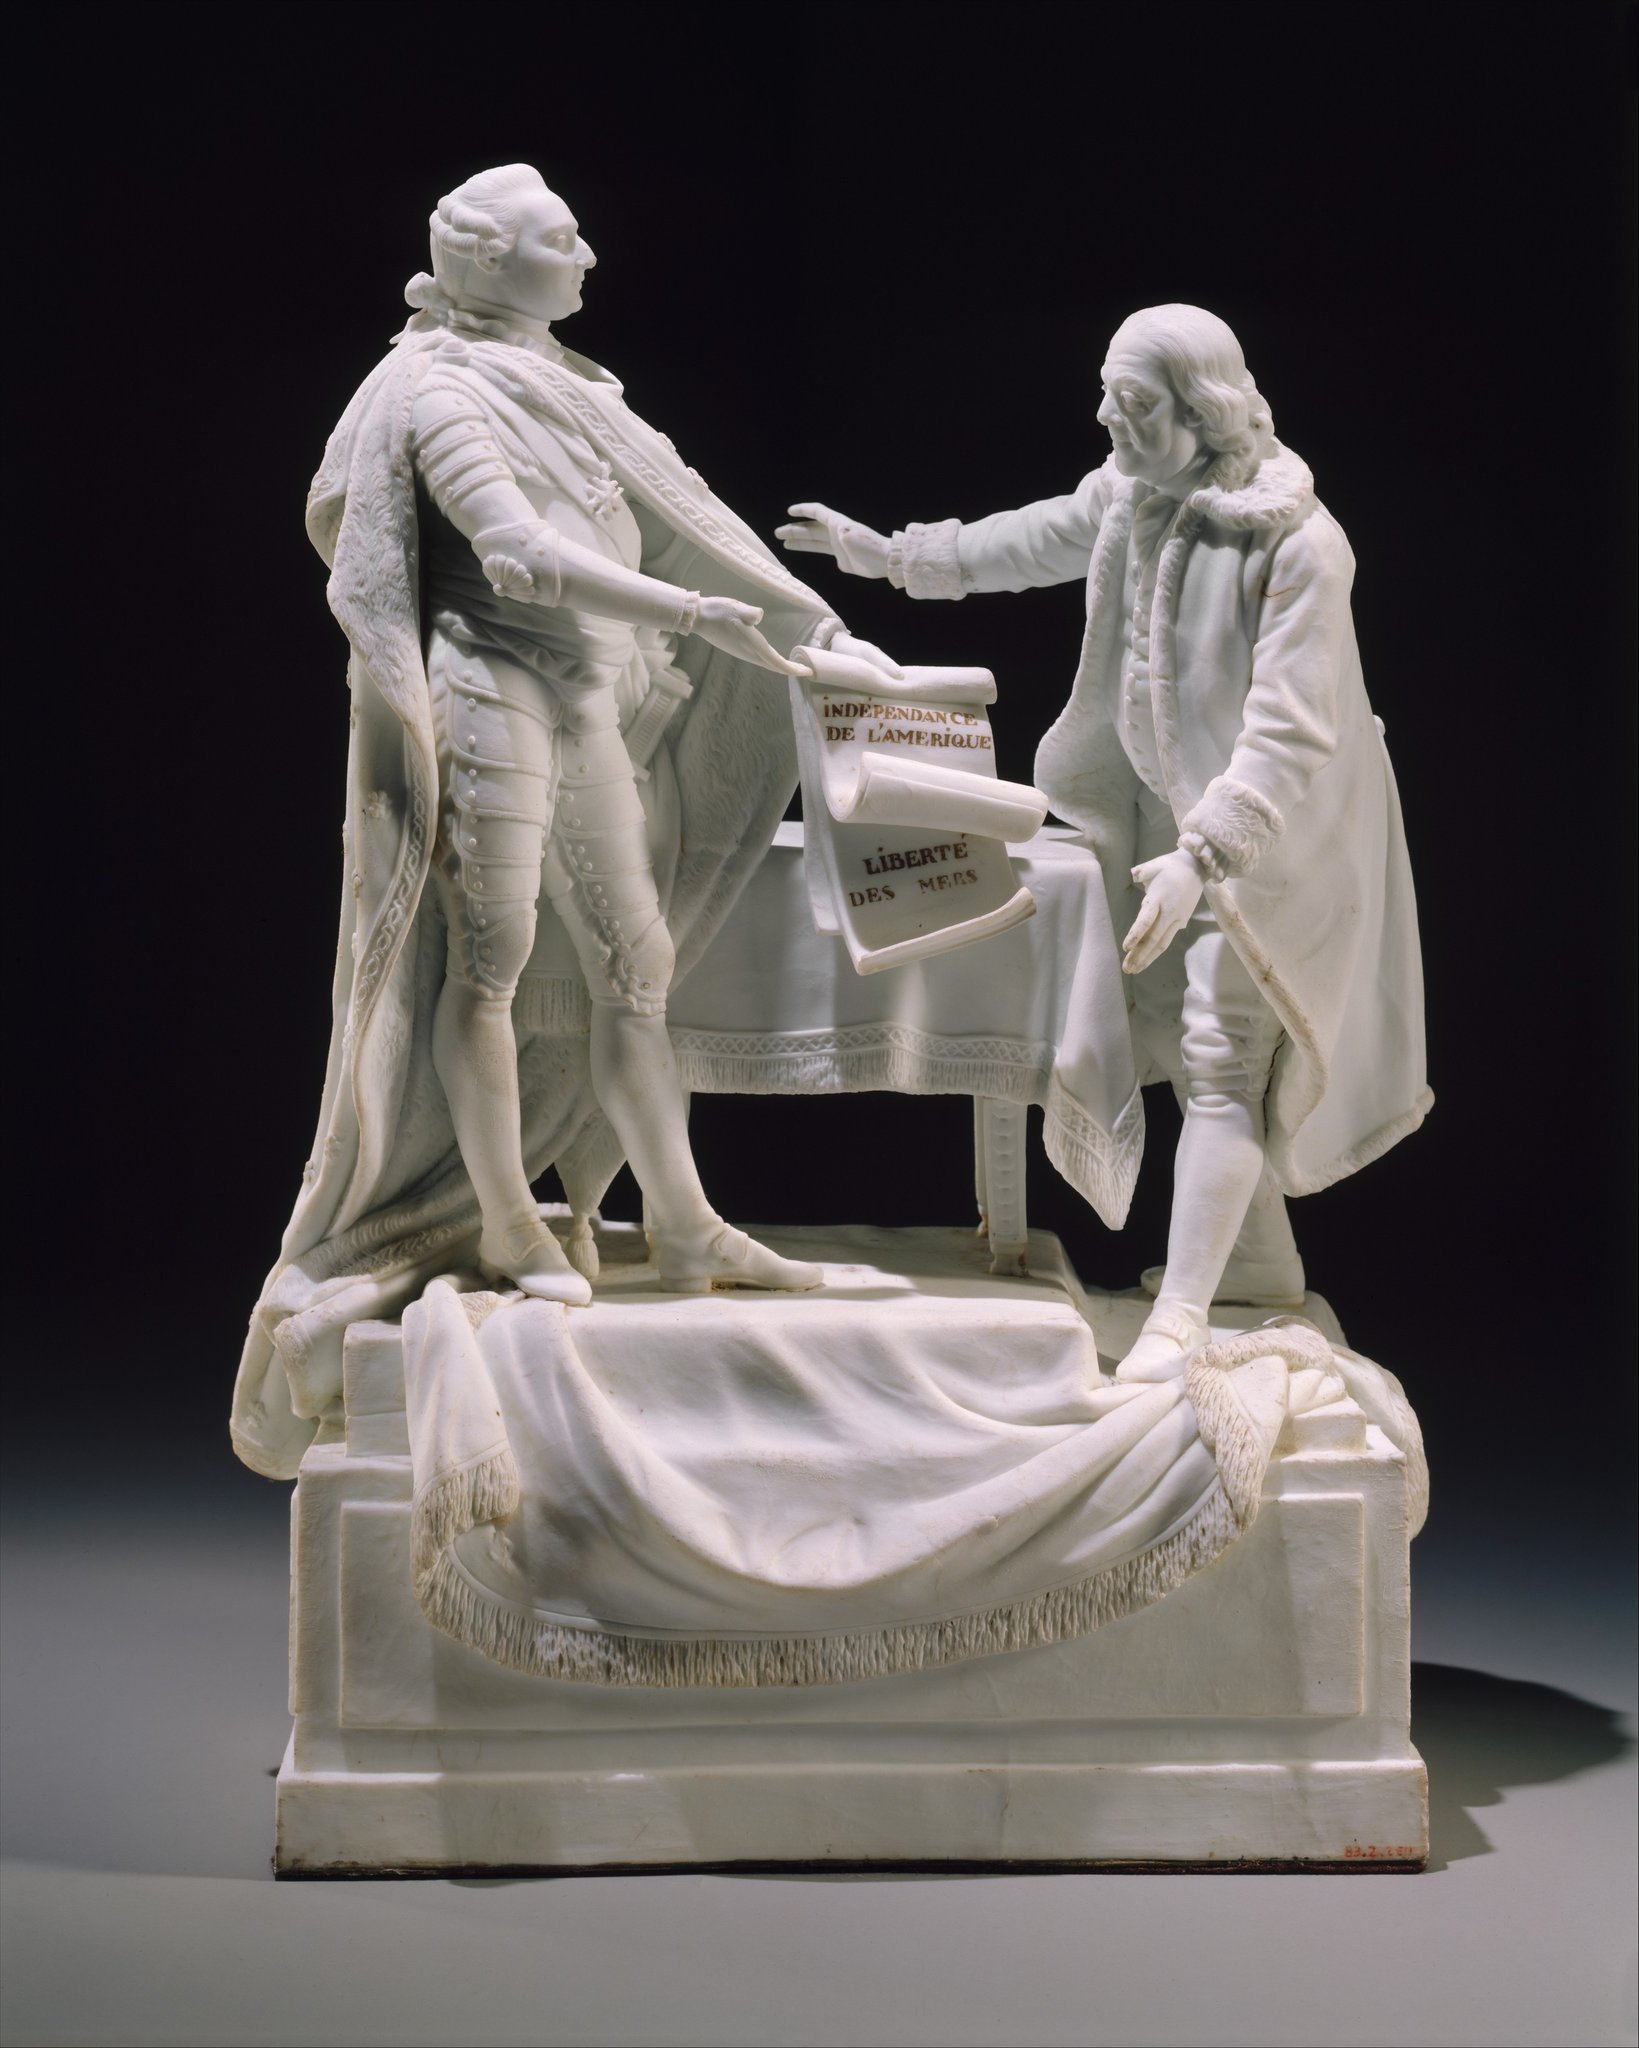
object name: figure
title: Figure of Louis XVI and Benjamin Franklin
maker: charles-gabriel sauvage, called lemire pere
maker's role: artist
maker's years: 1741-1827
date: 1780-1785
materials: porcelain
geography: france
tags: benjamin franklin,kings,louis xvi,men